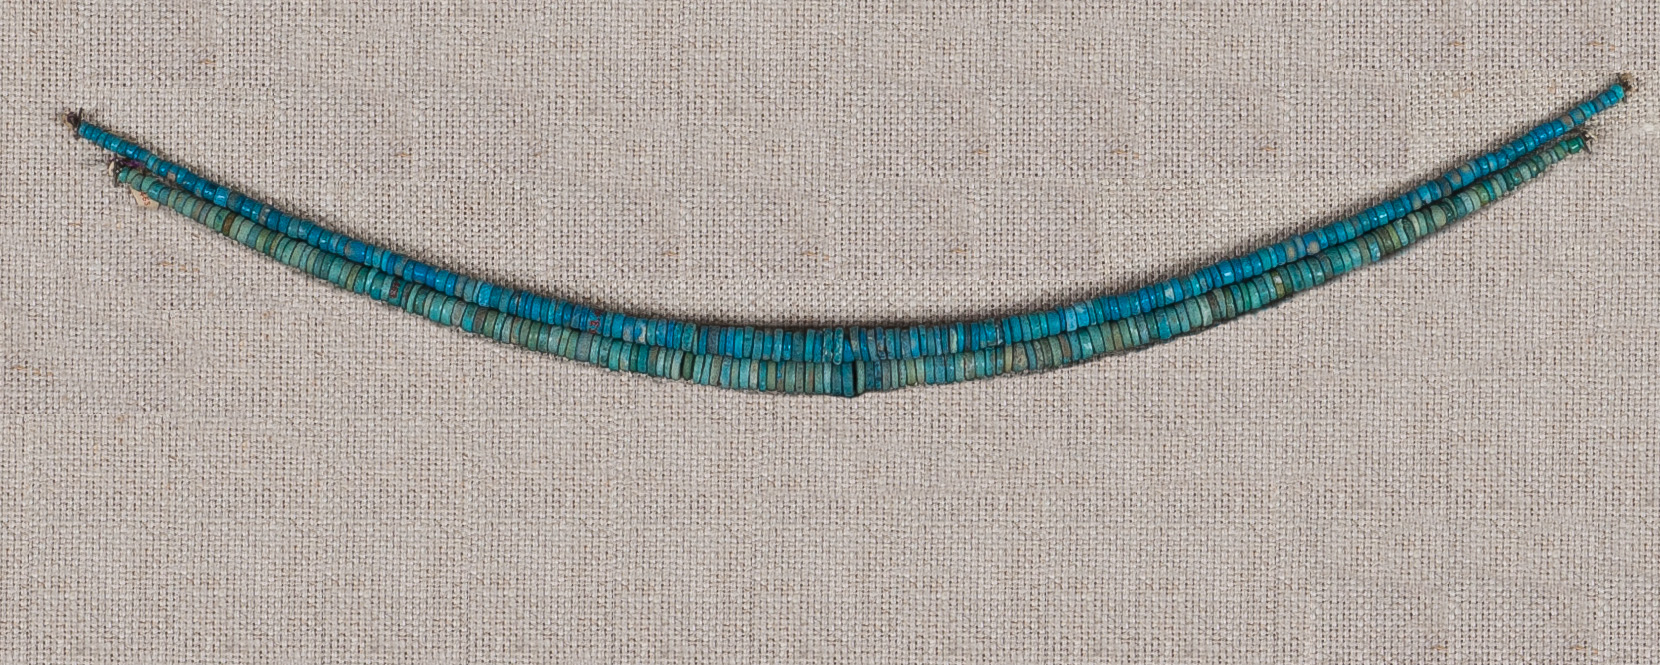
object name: necklace, bead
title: Necklace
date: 1981-1295 BCE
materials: faience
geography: egypt